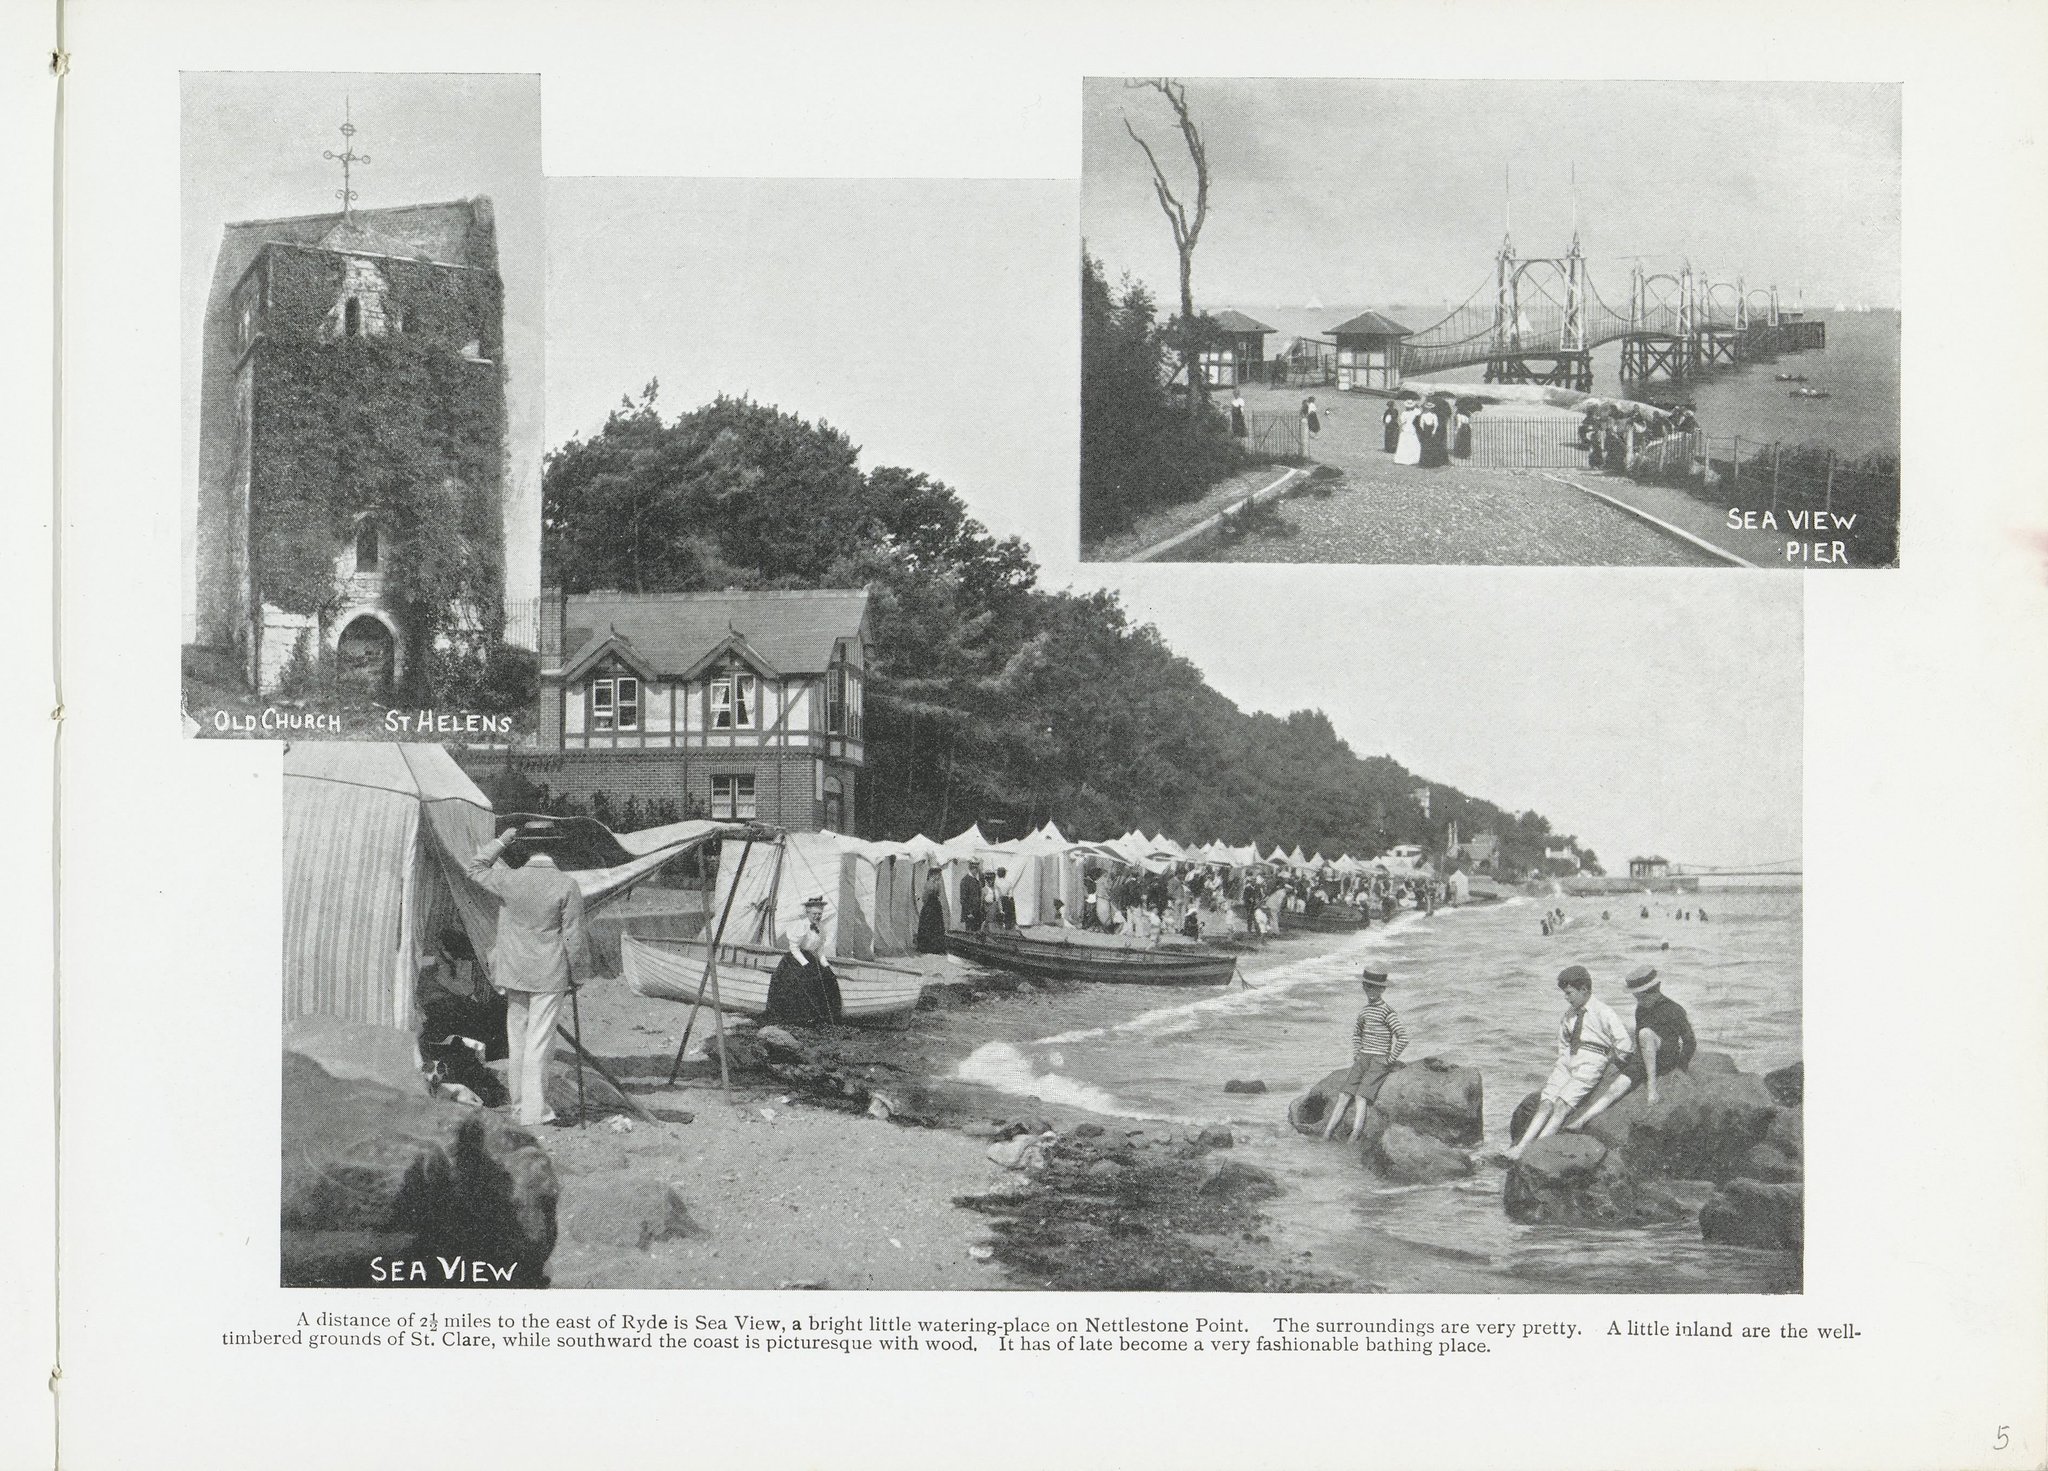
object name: page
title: Old Church in St. Helens en Seaview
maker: Anonymous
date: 1897-1930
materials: paper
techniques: printing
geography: isle of wight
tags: beach (as place of recreation), church (exterior), travelling; tourism, pier, quay, wharf, isle of wight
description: Pagina 5 met 3 foto's van de Old Church in St. Helens, de pier en het strand van Seaview en een bijschrift. Onderdeel van Fotografische reisreportage van het eiland Wight.